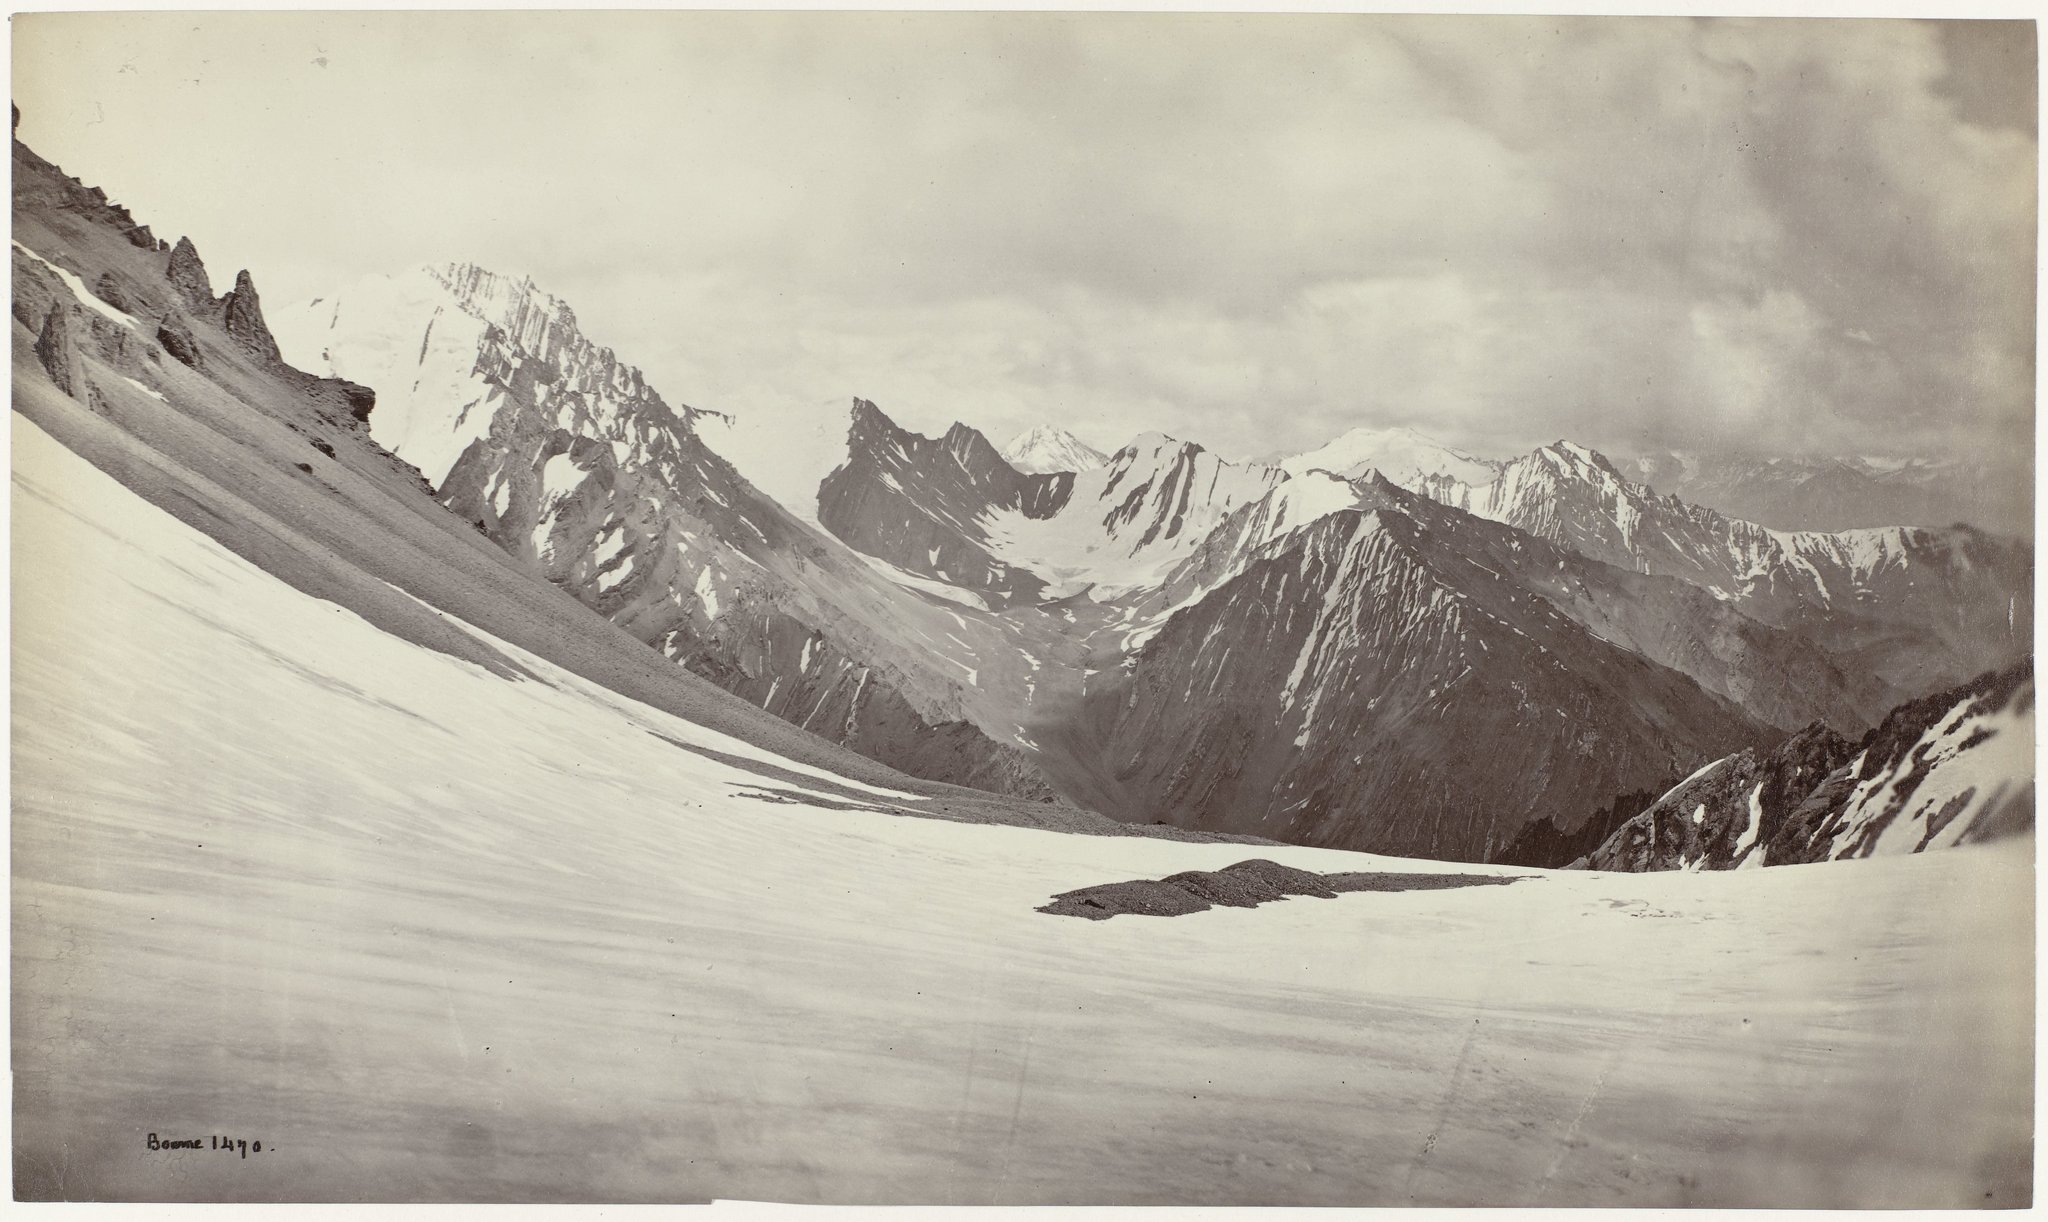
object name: photograph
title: View from the Manirang Pass, showing a succession of snowy summits, Himachal Pradesh, India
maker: samuel bourne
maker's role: fotograaf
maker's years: 1834-1912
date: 1864-1866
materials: paper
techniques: albumen print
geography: manirang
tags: mountain-range, snow peaks, mountains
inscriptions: name: ‘Bourne’, inscription: ‘5/ 2/ 18/ 49/ 22’, number: ‘1470’